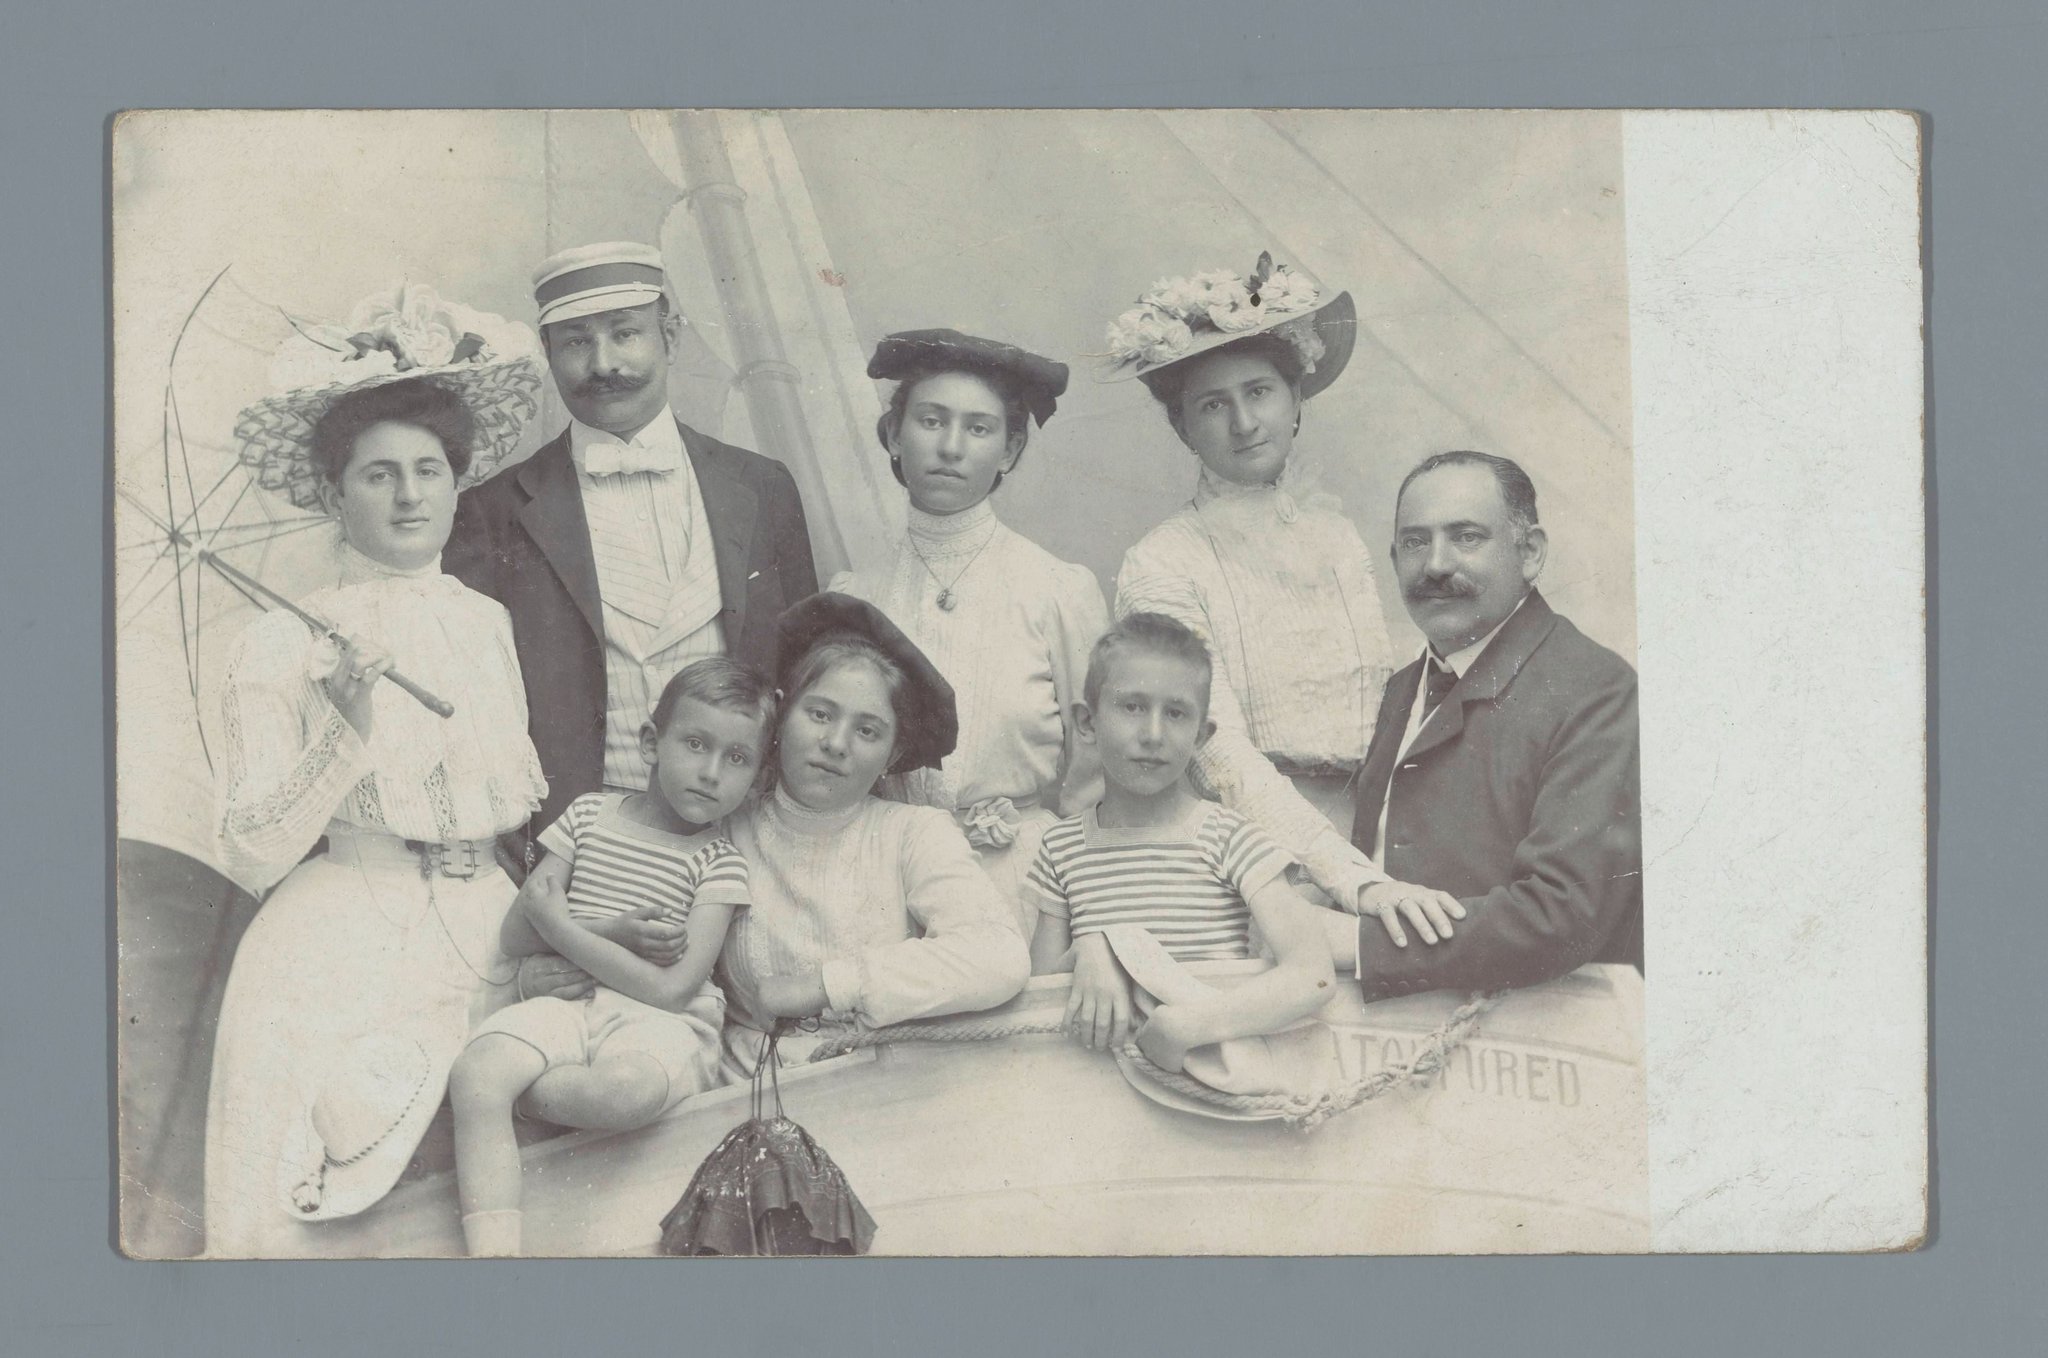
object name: ansichtkaart, prentbriefkaart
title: Studioportret van (vermoedelijk) een gezin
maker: Anonymous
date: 1900-1907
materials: photographic support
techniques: gelatin silver print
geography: hungary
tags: studio ~ photographer, family group, especially parents with their child(ren), anonymous historical persons portrayed in a group, in a group-portrait